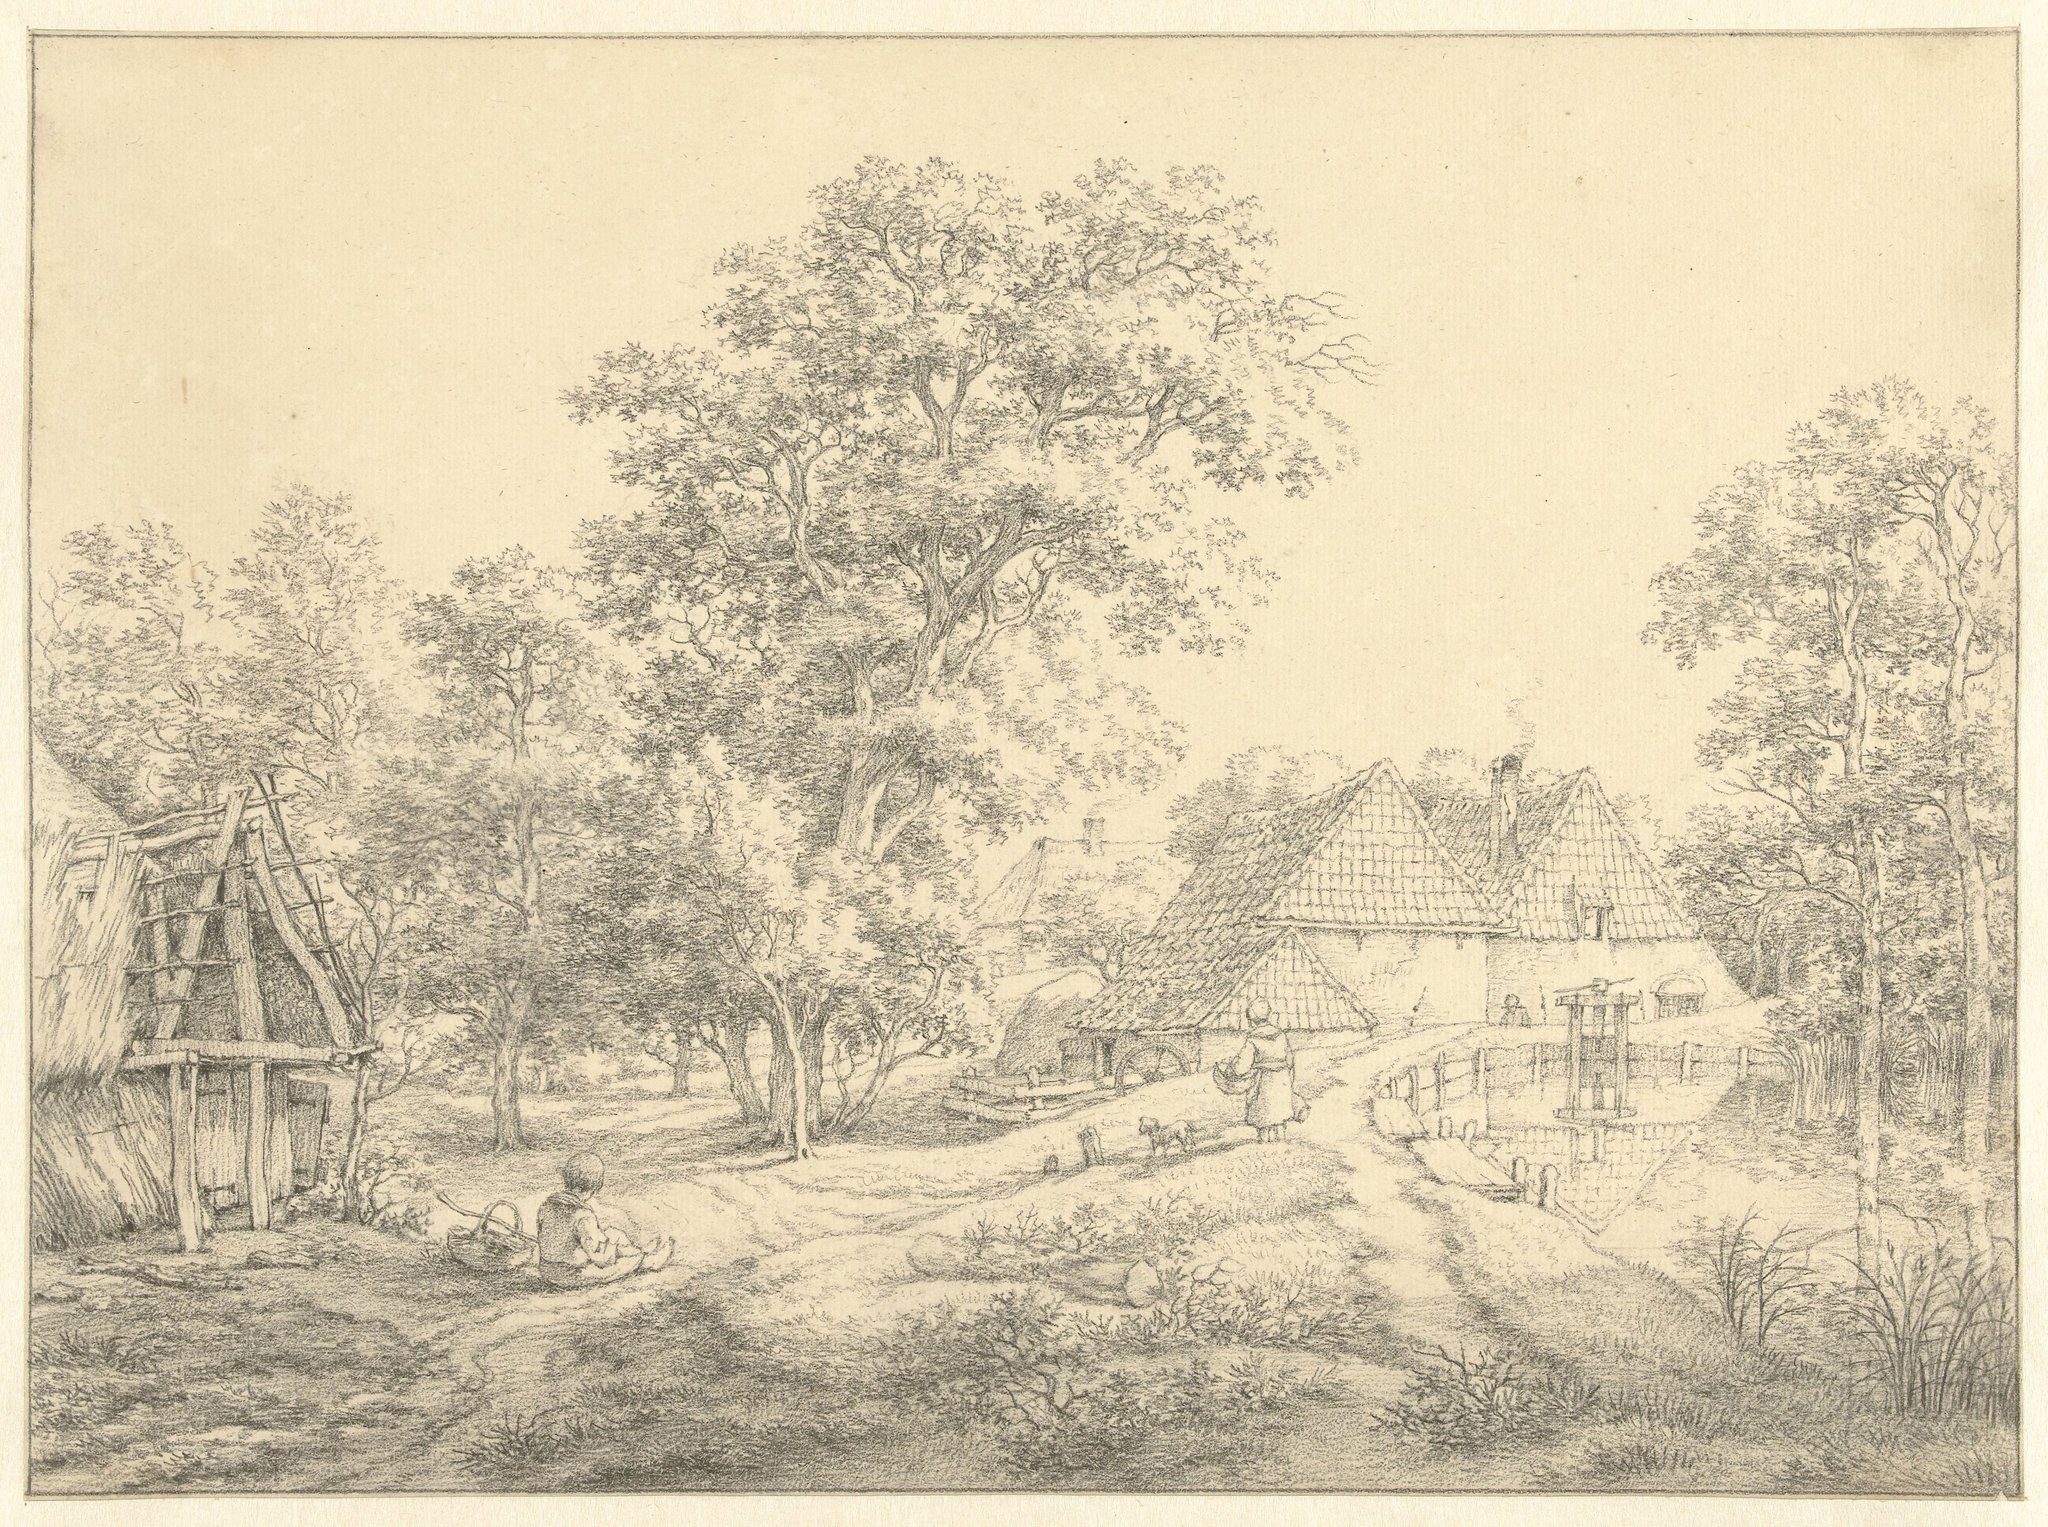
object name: drawing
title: Landschap met boerderijen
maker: daniël kerkhoff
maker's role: draughtsman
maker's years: 1766-1821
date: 1776-1821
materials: chalk, paper